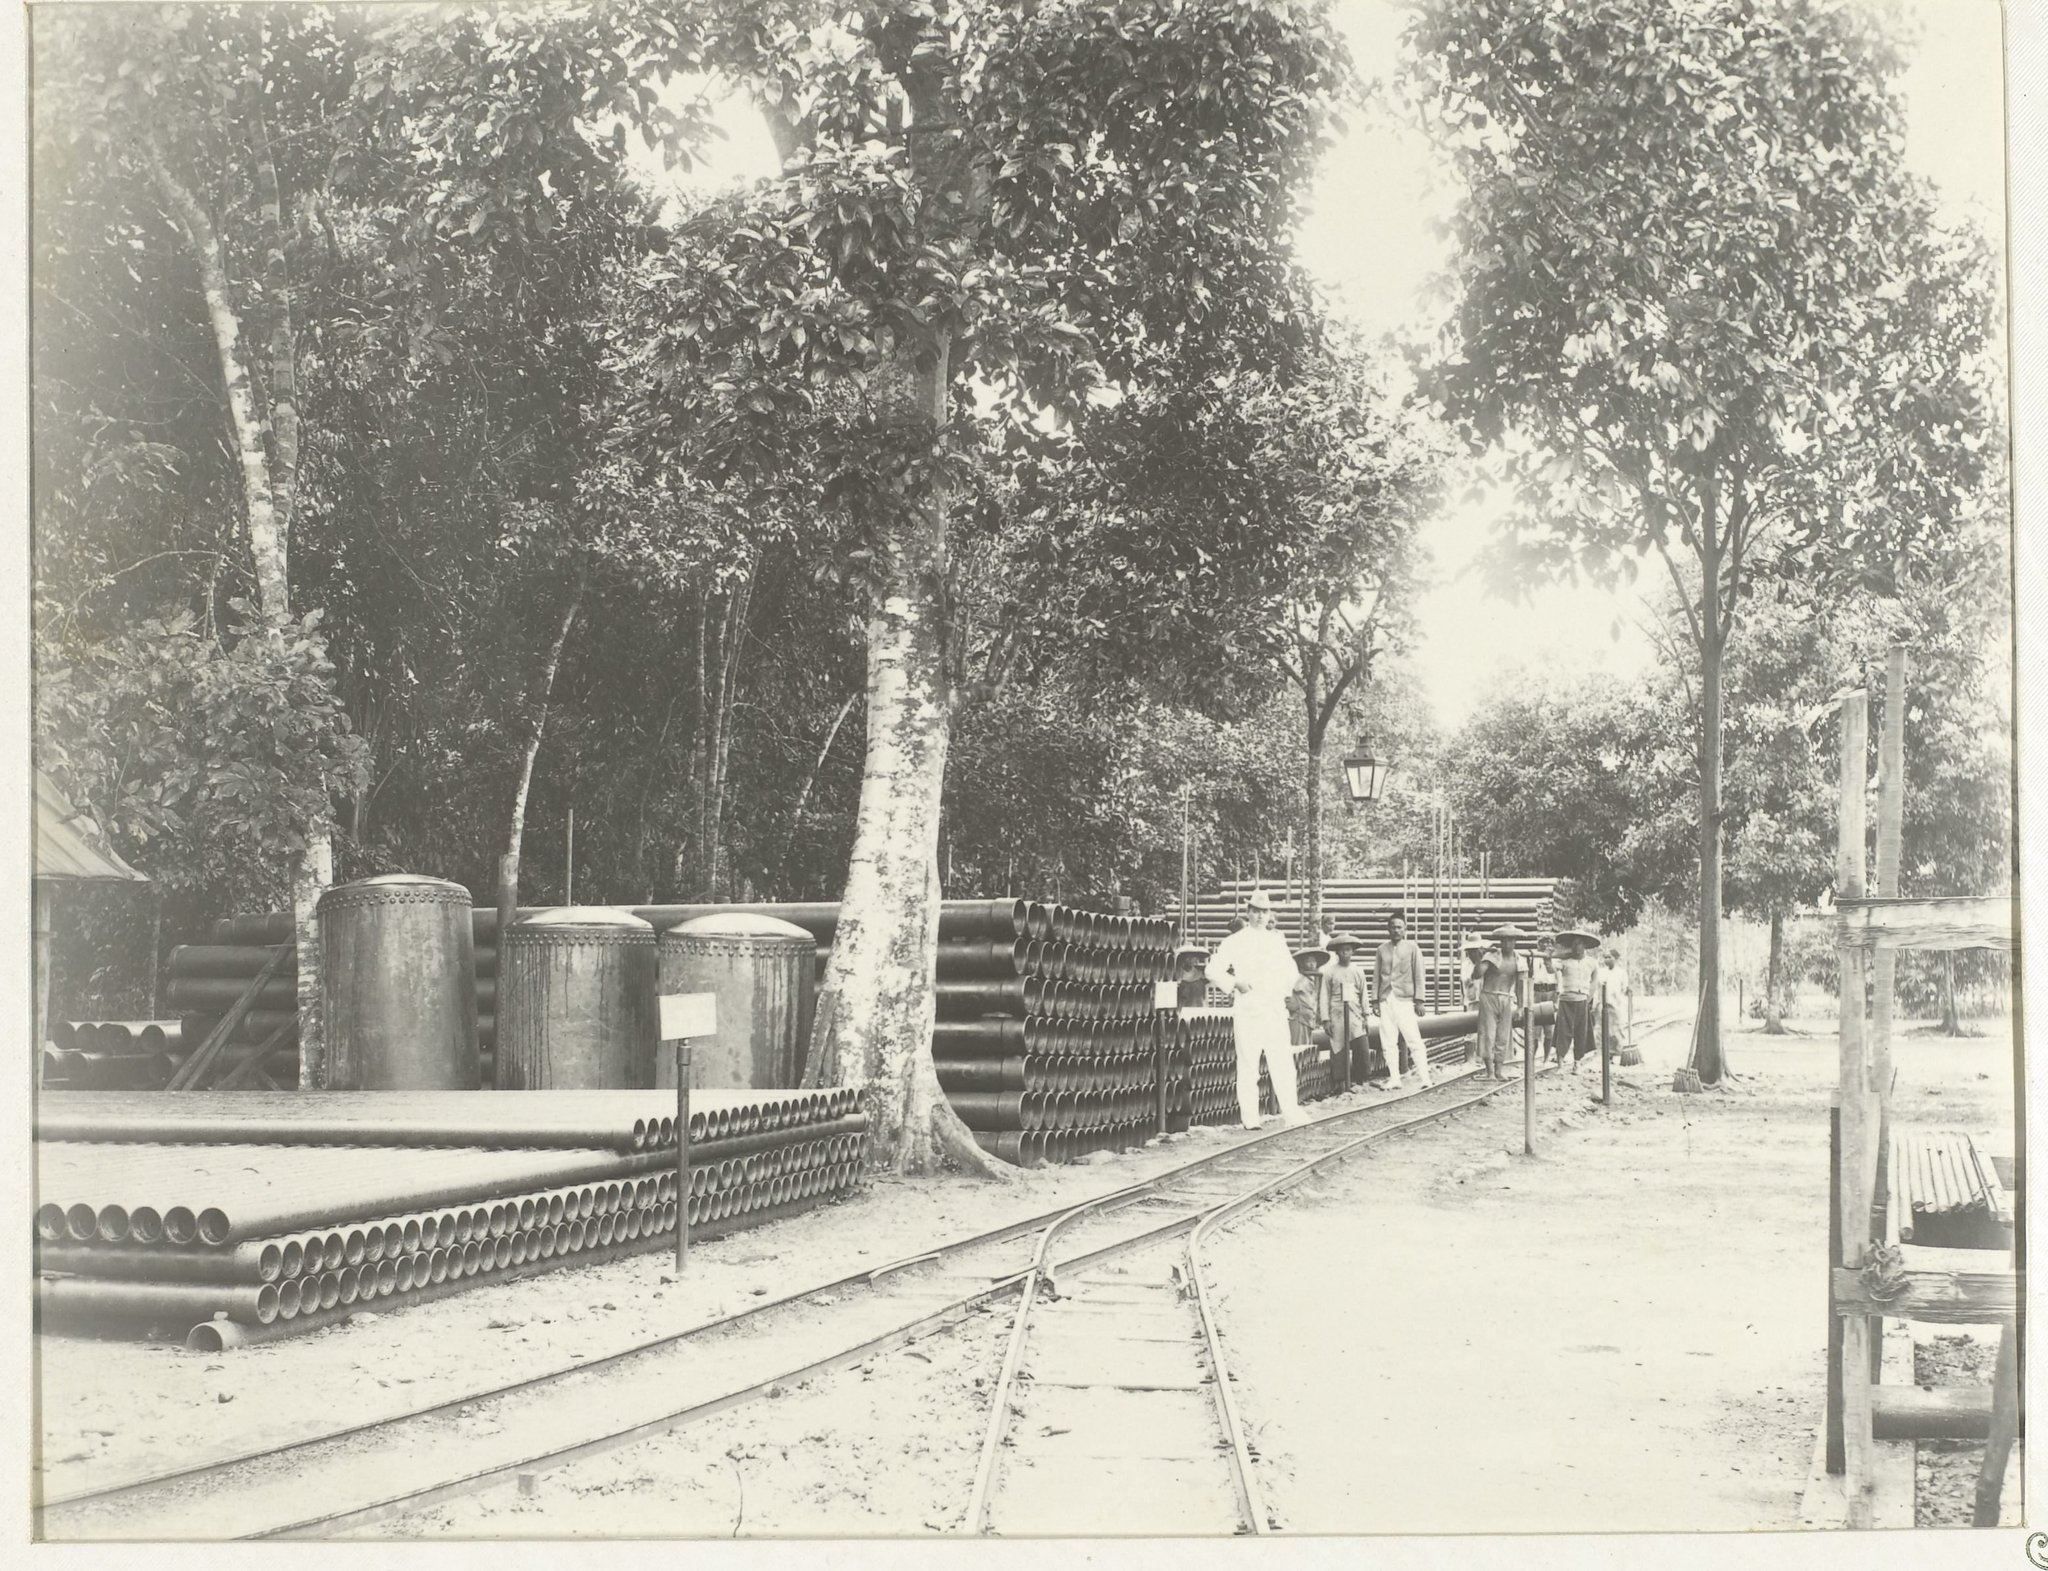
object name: album leaf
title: Boorpijpen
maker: Anonymous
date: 1903-1907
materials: paper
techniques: gelatin silver print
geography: kalimantan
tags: drilling for oil, borneo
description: Opslagterrein voor pijpen en buizen voor gebruik bij het boren naar olie. Over het terrein loopt een spoorbaan, bij een stapel buizen staan een Europeaan en enkele arbeiders. Foto in het fotoalbum over de oliewinning op Borneo door de Koninklijke Nederlandsche Petroleum Maatschappij (KNPM) in de jaren 1903-1907.